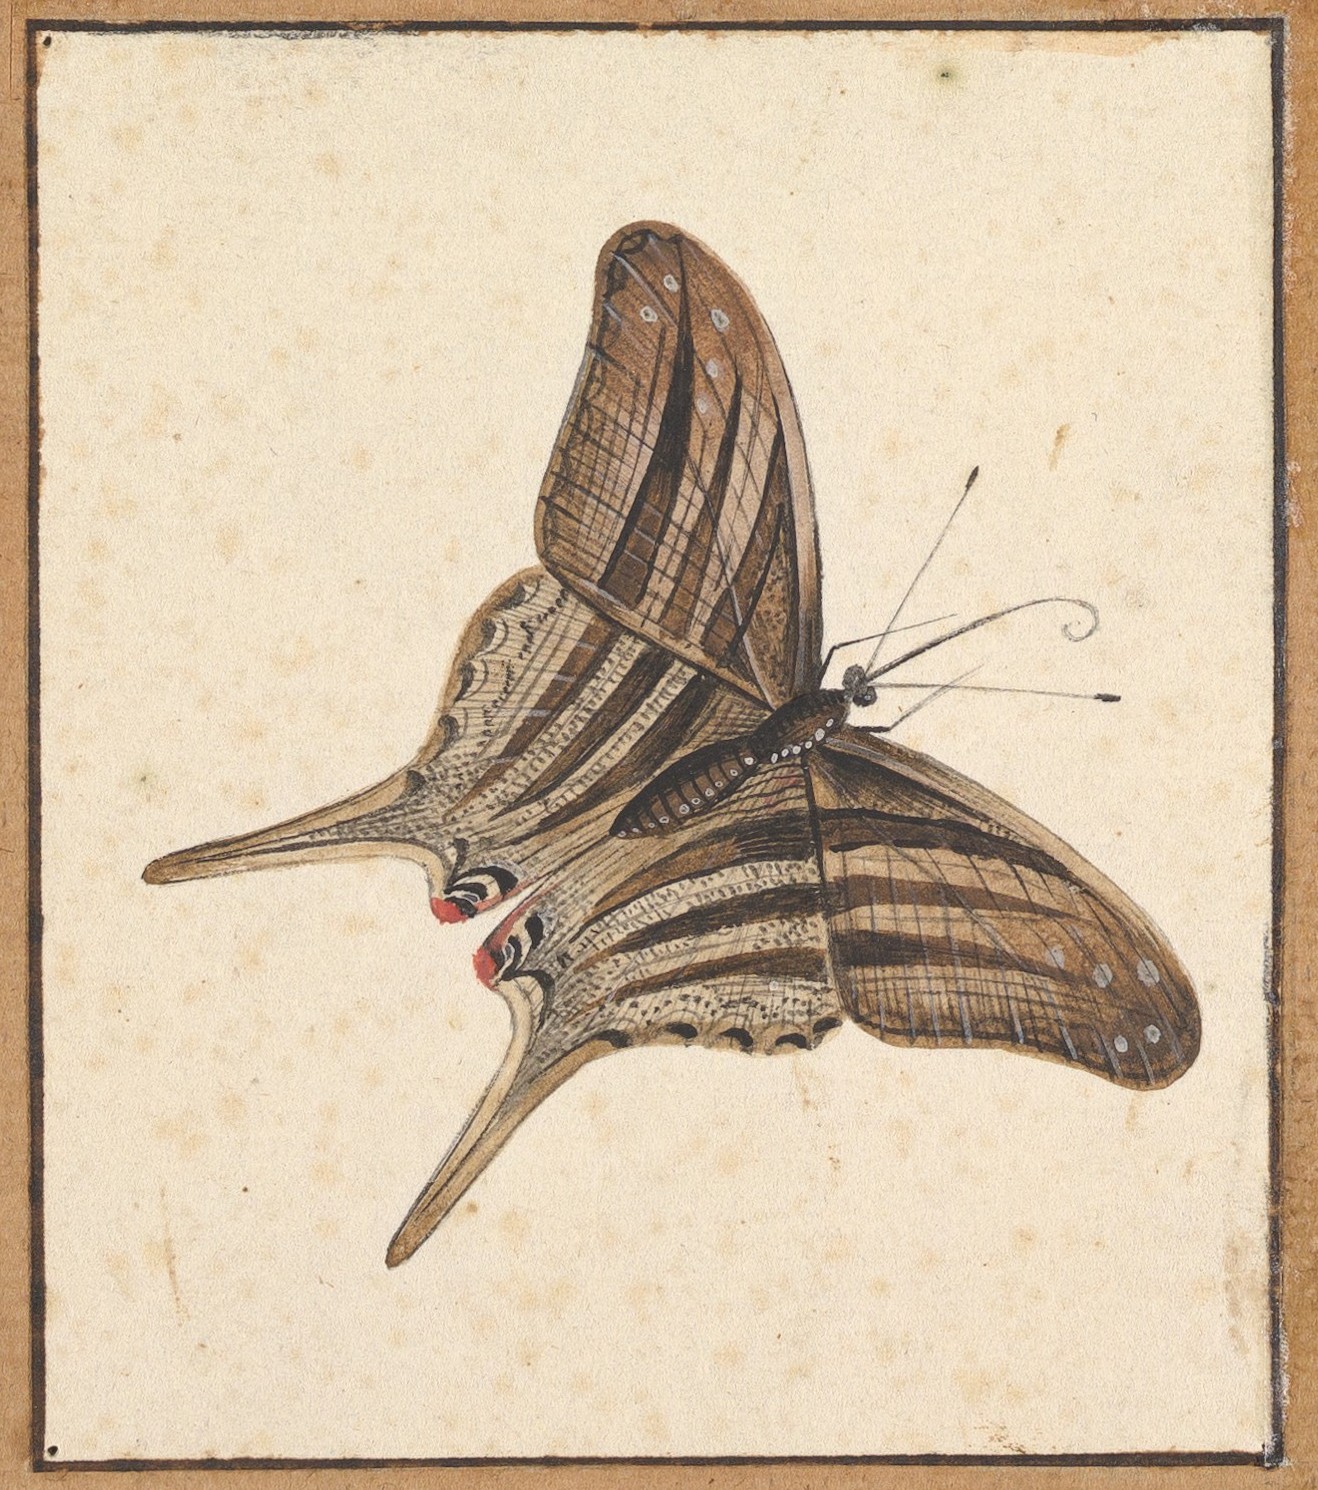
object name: drawing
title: A Butterfly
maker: nicolaas struyk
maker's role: artist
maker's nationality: dutch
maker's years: 1686-1769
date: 1701-1766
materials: graphite, ink, watercolor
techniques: pen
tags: butterflies